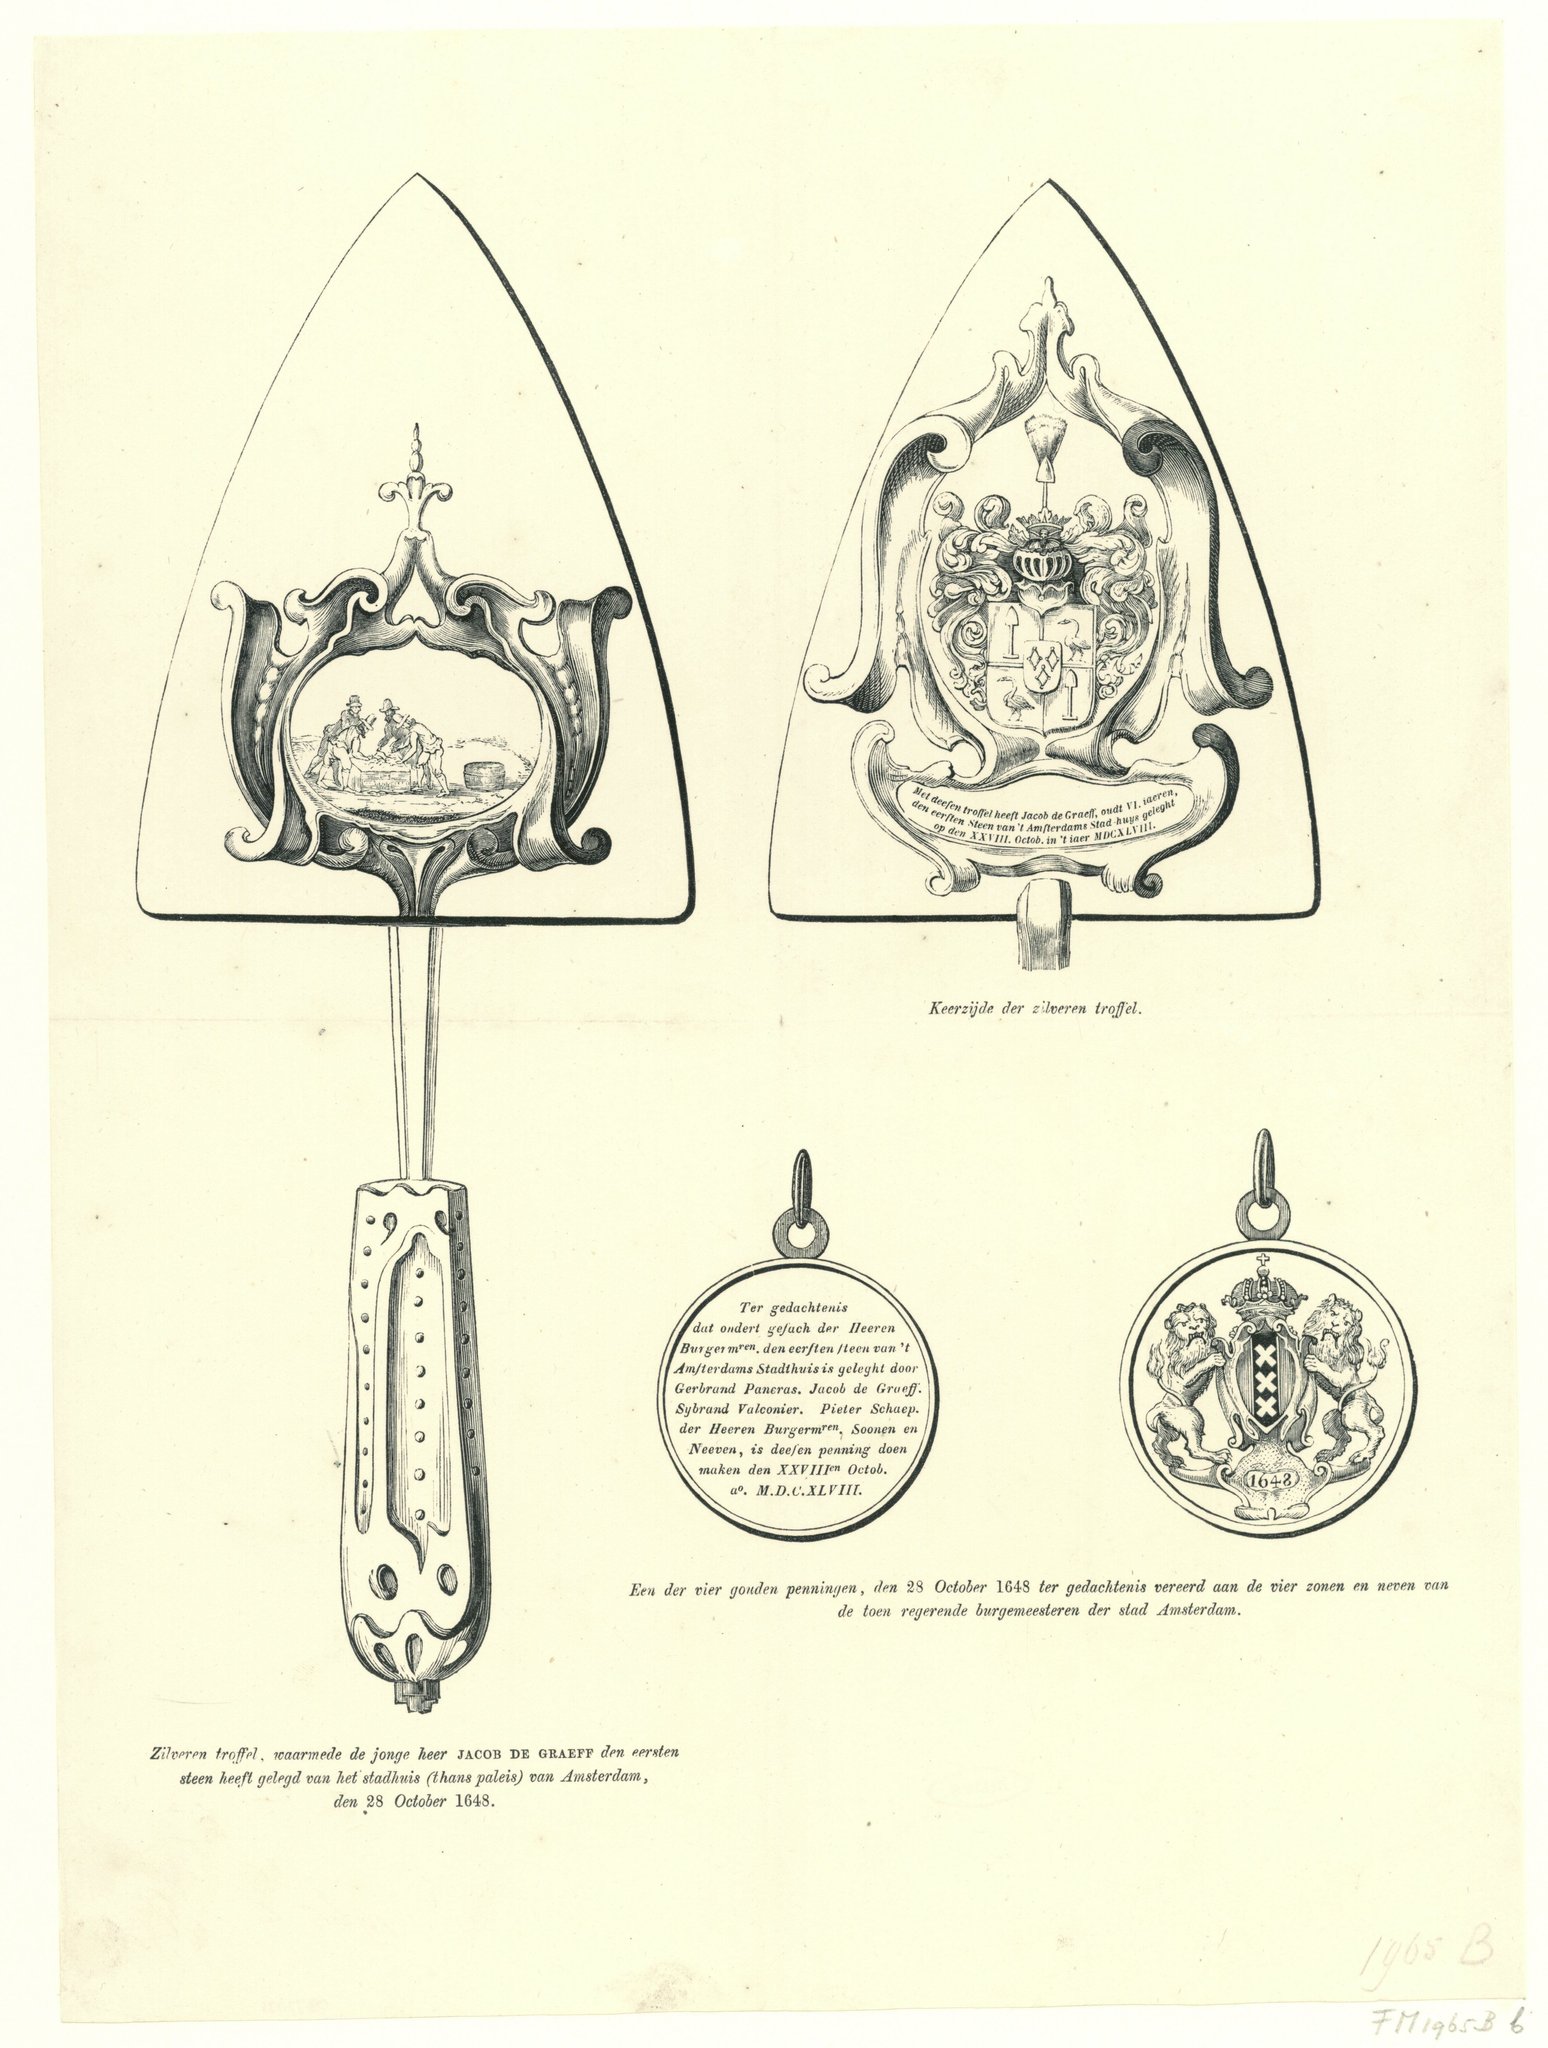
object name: historical object representation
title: Zilveren troffel, waarmede de jonge heer Jacob de Graeff den eersten steen heeft gelegd van het stadhuis (thans paleis) van Amsterdam, den 28 October 1648 / Een der vier gouden penningen, den 28 October 1648 ter gedachtenis vereerd aan de vier zonen en neven van de toen regerende burgemeesteren der stad Amsterdam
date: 1850-1924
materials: paper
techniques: engraving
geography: netherlands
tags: tools and machines ~ building, decorations, honours (as symbols of the state, etc.)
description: Moderne afbeelding van de zilveren troffel waarmee Jacob de Graeff op 28 oktober 1648 de eerste steen heeft gelegd voor het nieuwe stadhuis van Amsterdam. De voorstelling toont zowel de voorzijde als de achterzijde van de troffel. Op hetzelfde blad een afbeelding van een van de vier gouden penningen die bij deze gelegenheid werden vervaardigd. De troffel wordt toegeschreven aan Johannes Lutma en bevindt zich in de collectie van het Koninklijk Oudheidkundig Genootschap (BK-KOG-1494).